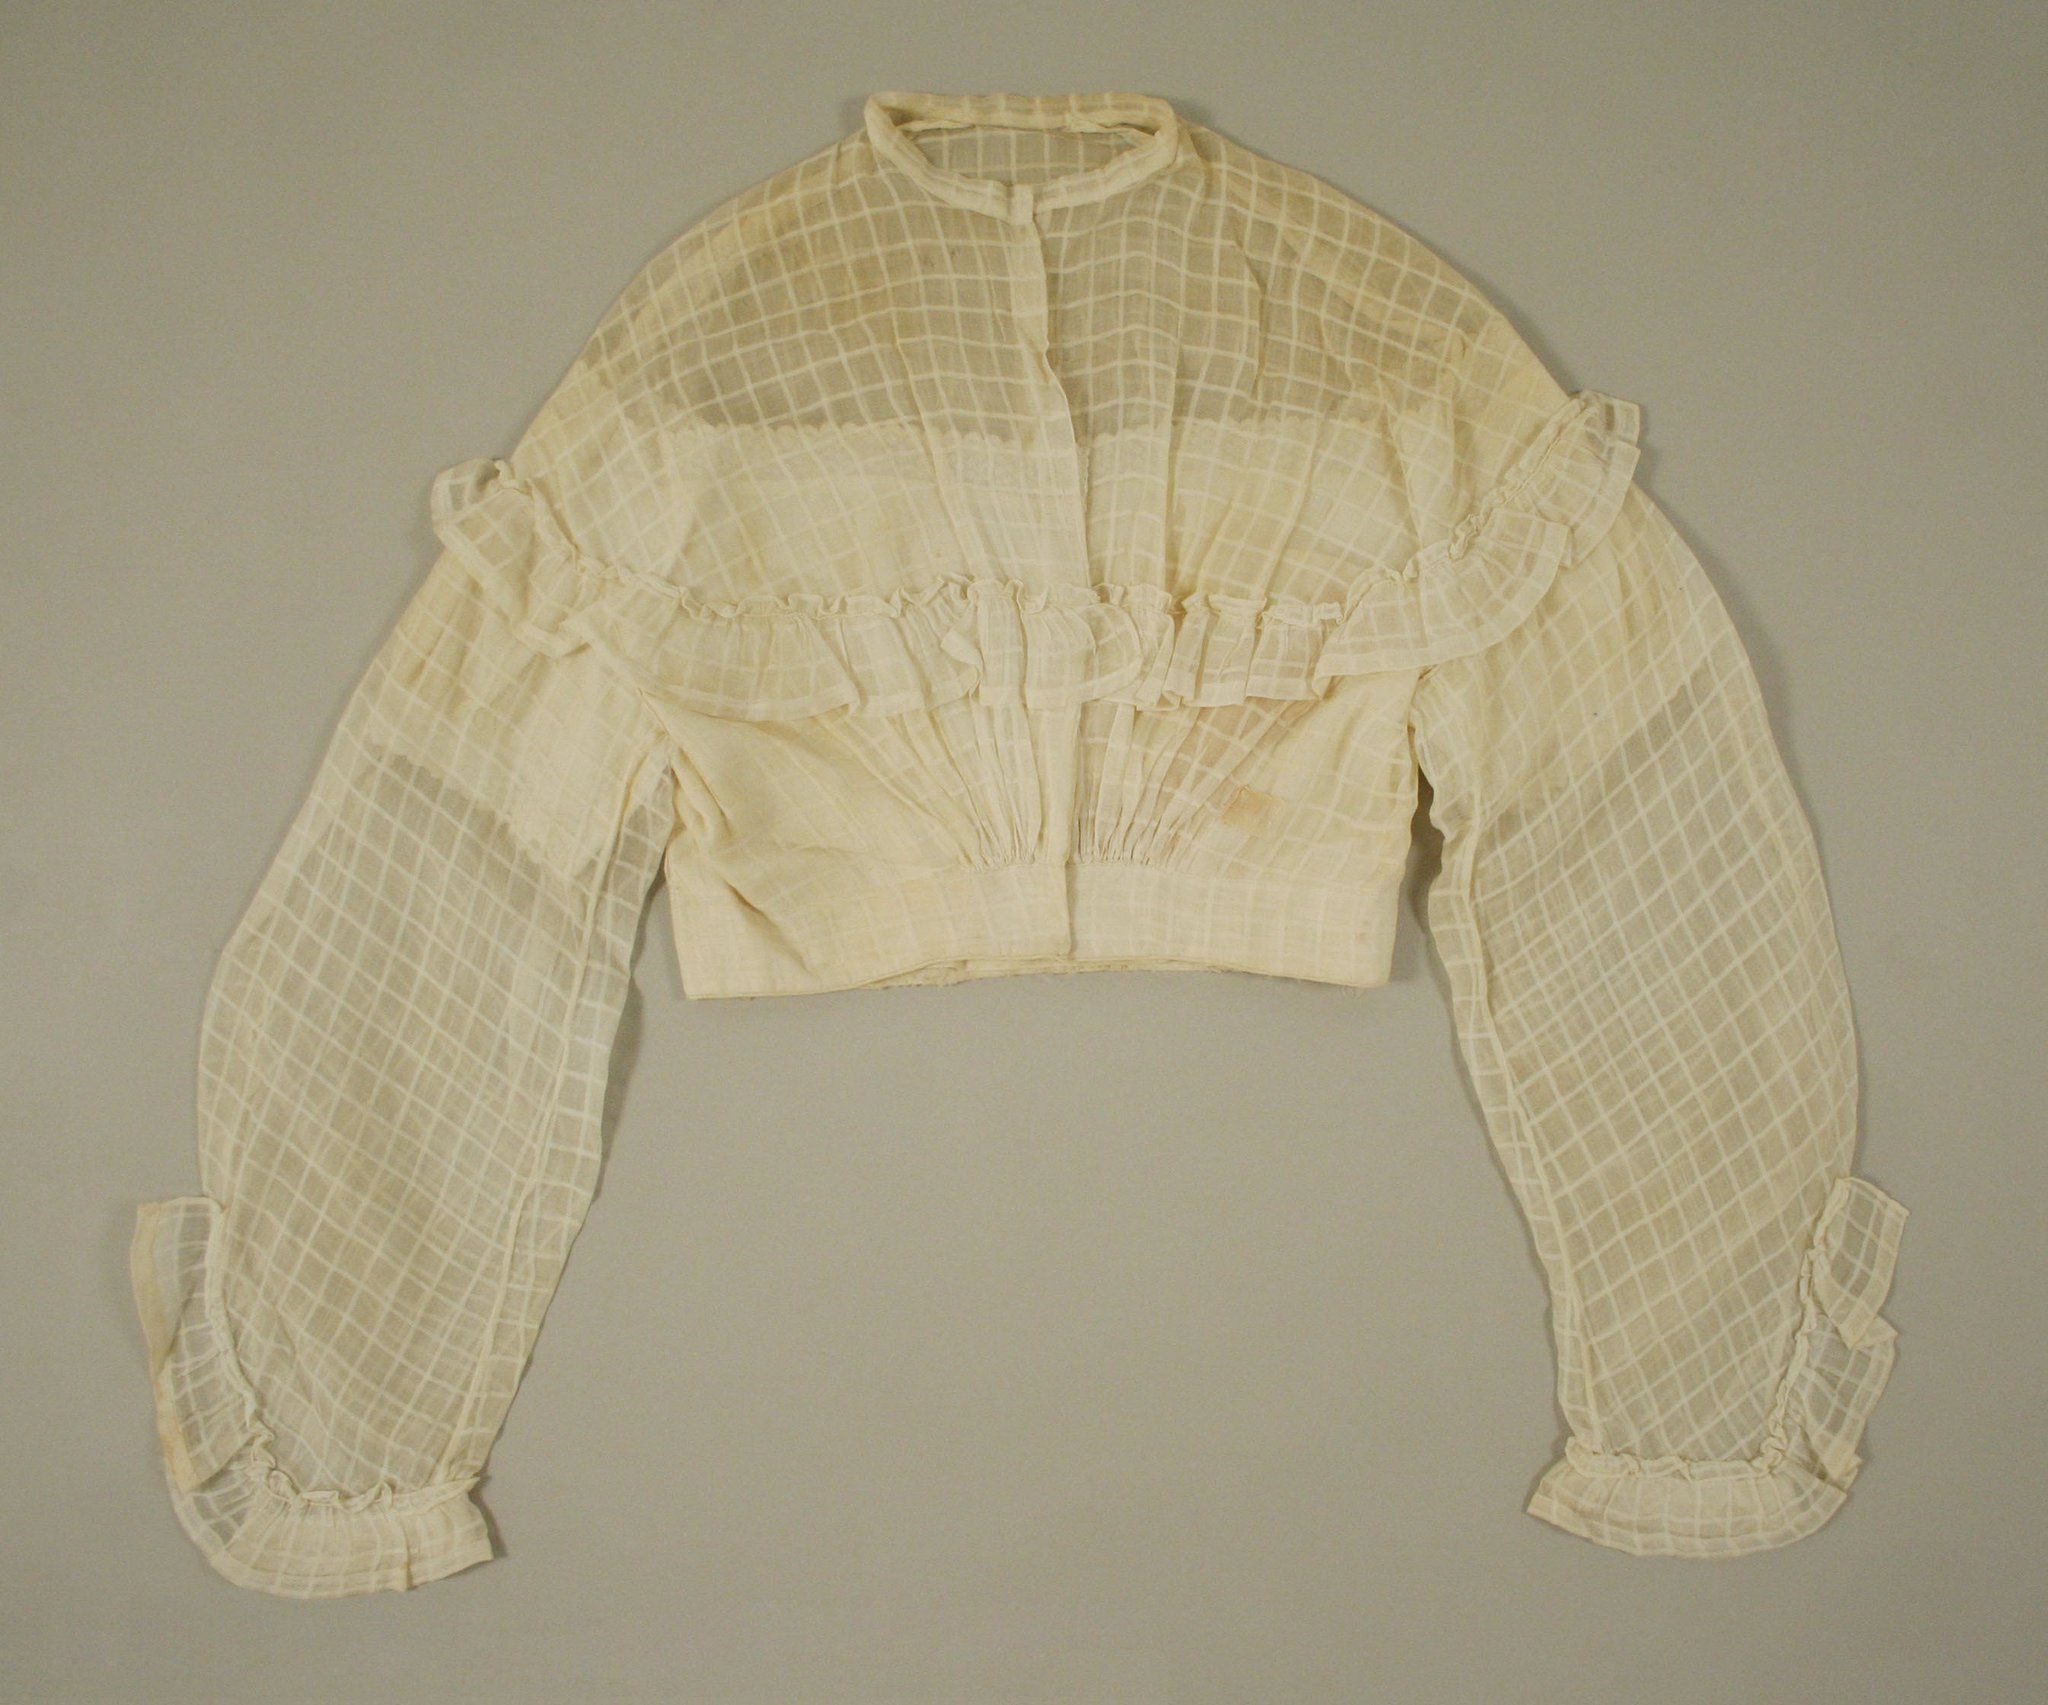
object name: bodice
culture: american or european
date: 1860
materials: cotton